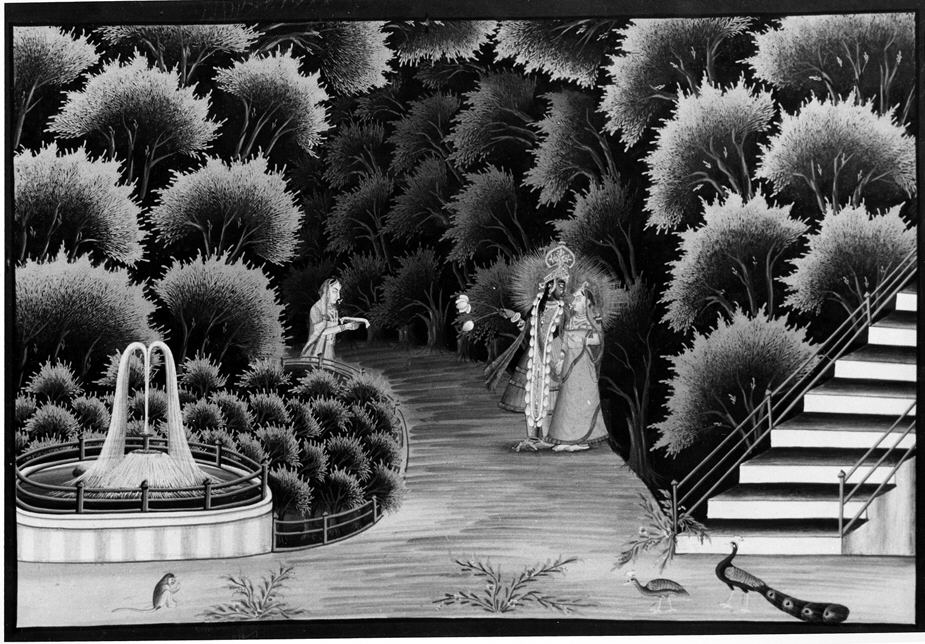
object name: painting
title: Krishna and Radha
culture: indian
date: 1901-2000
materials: gilt, ink, paper, watercolor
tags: fountains,women,peacocks,krishna,radha